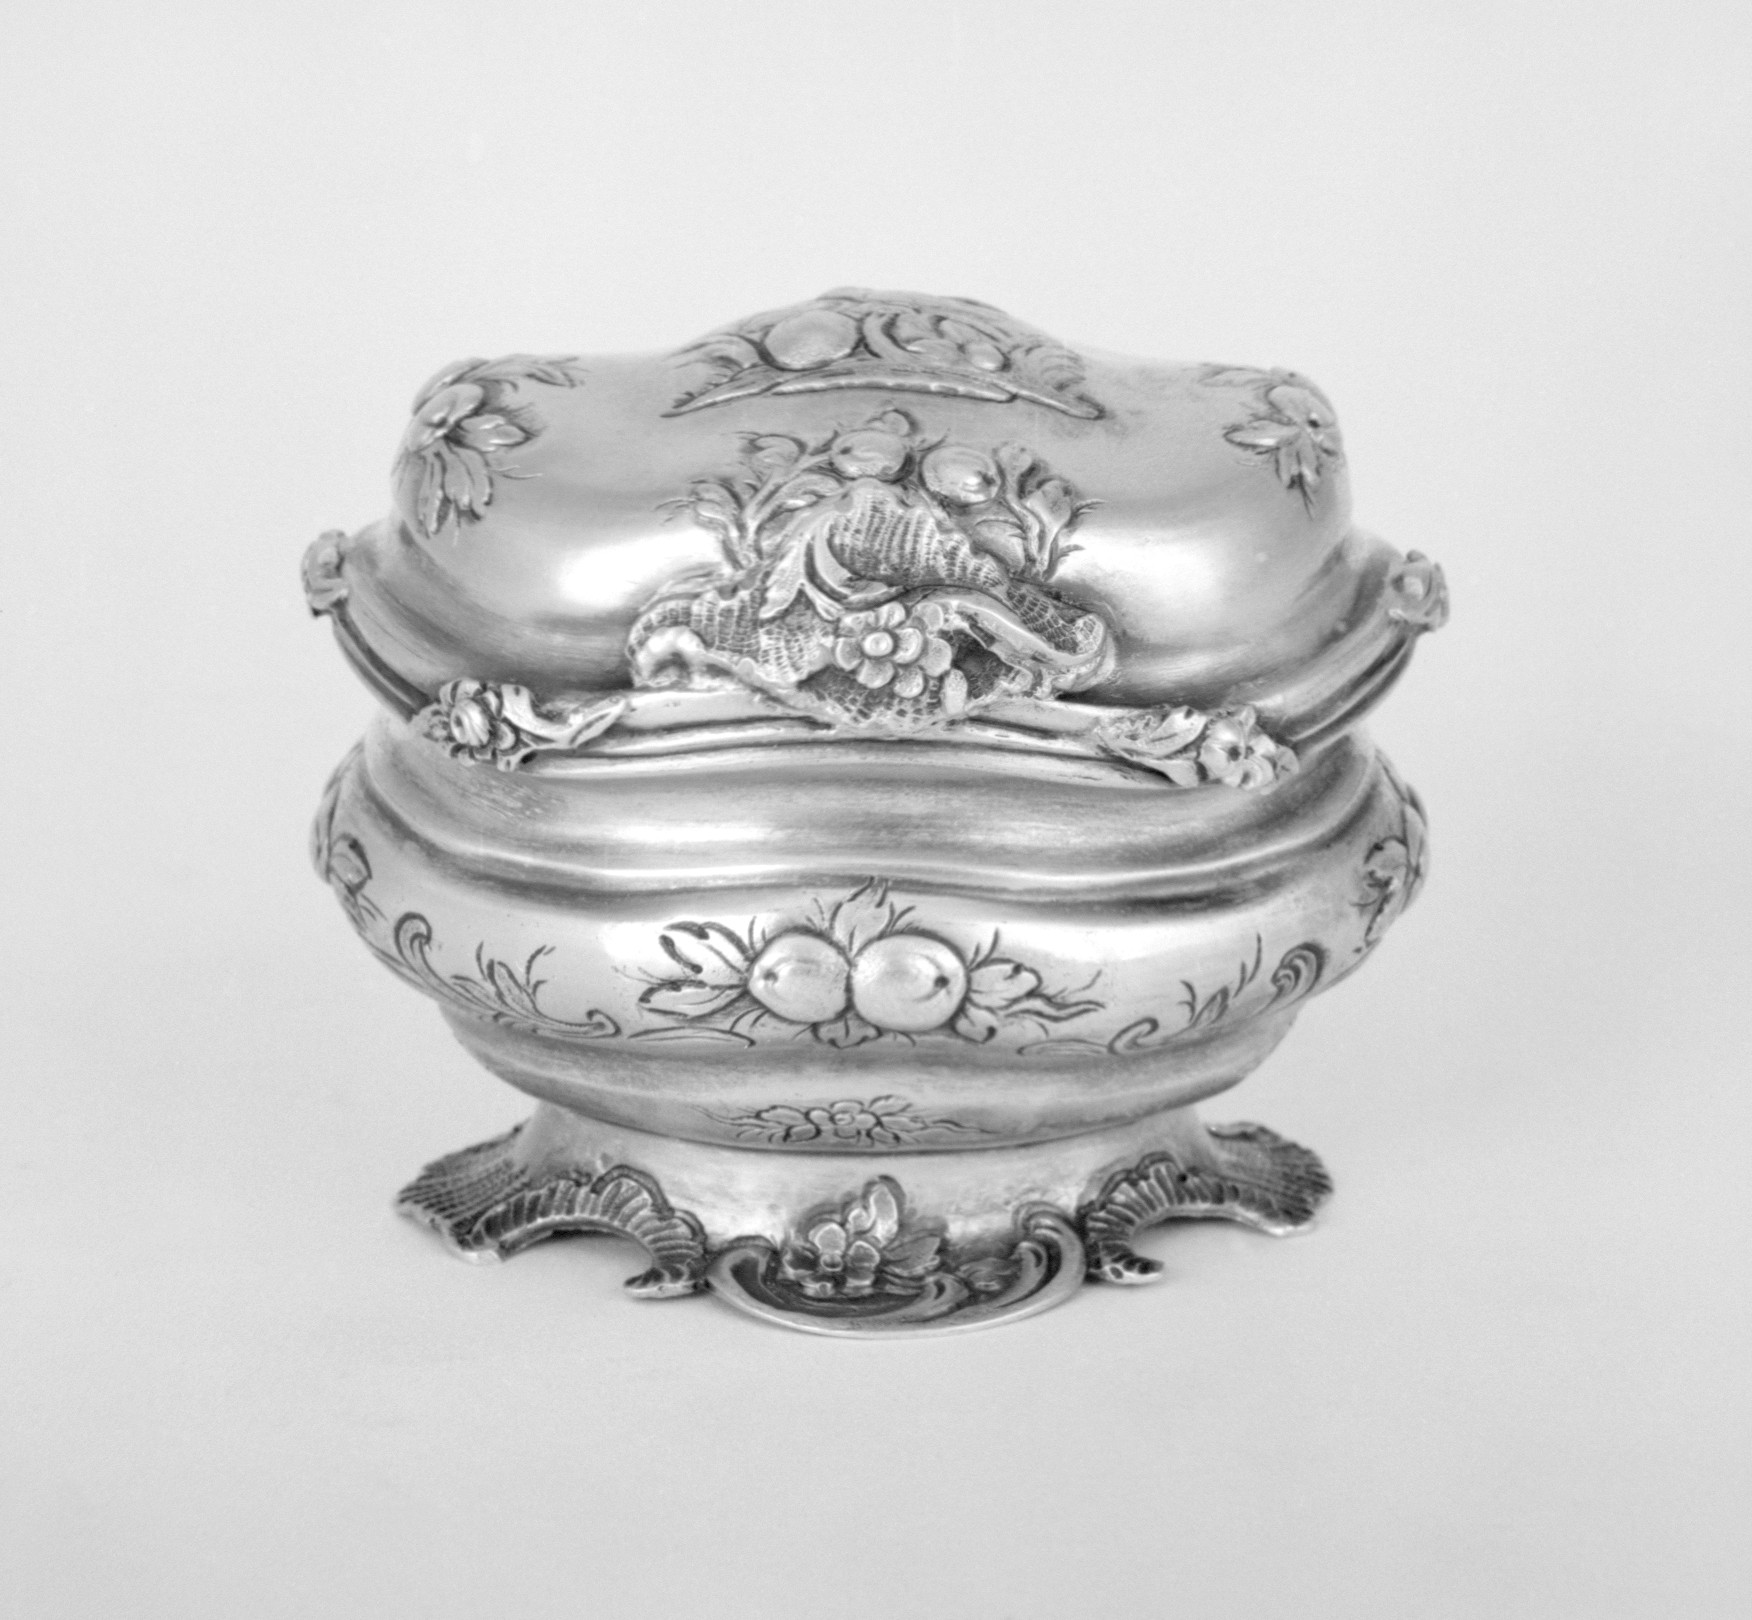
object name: box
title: Small oval box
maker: johann christian neuss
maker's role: maker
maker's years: 1740-1803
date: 1773-1775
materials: silver gilt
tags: fruit,flowers